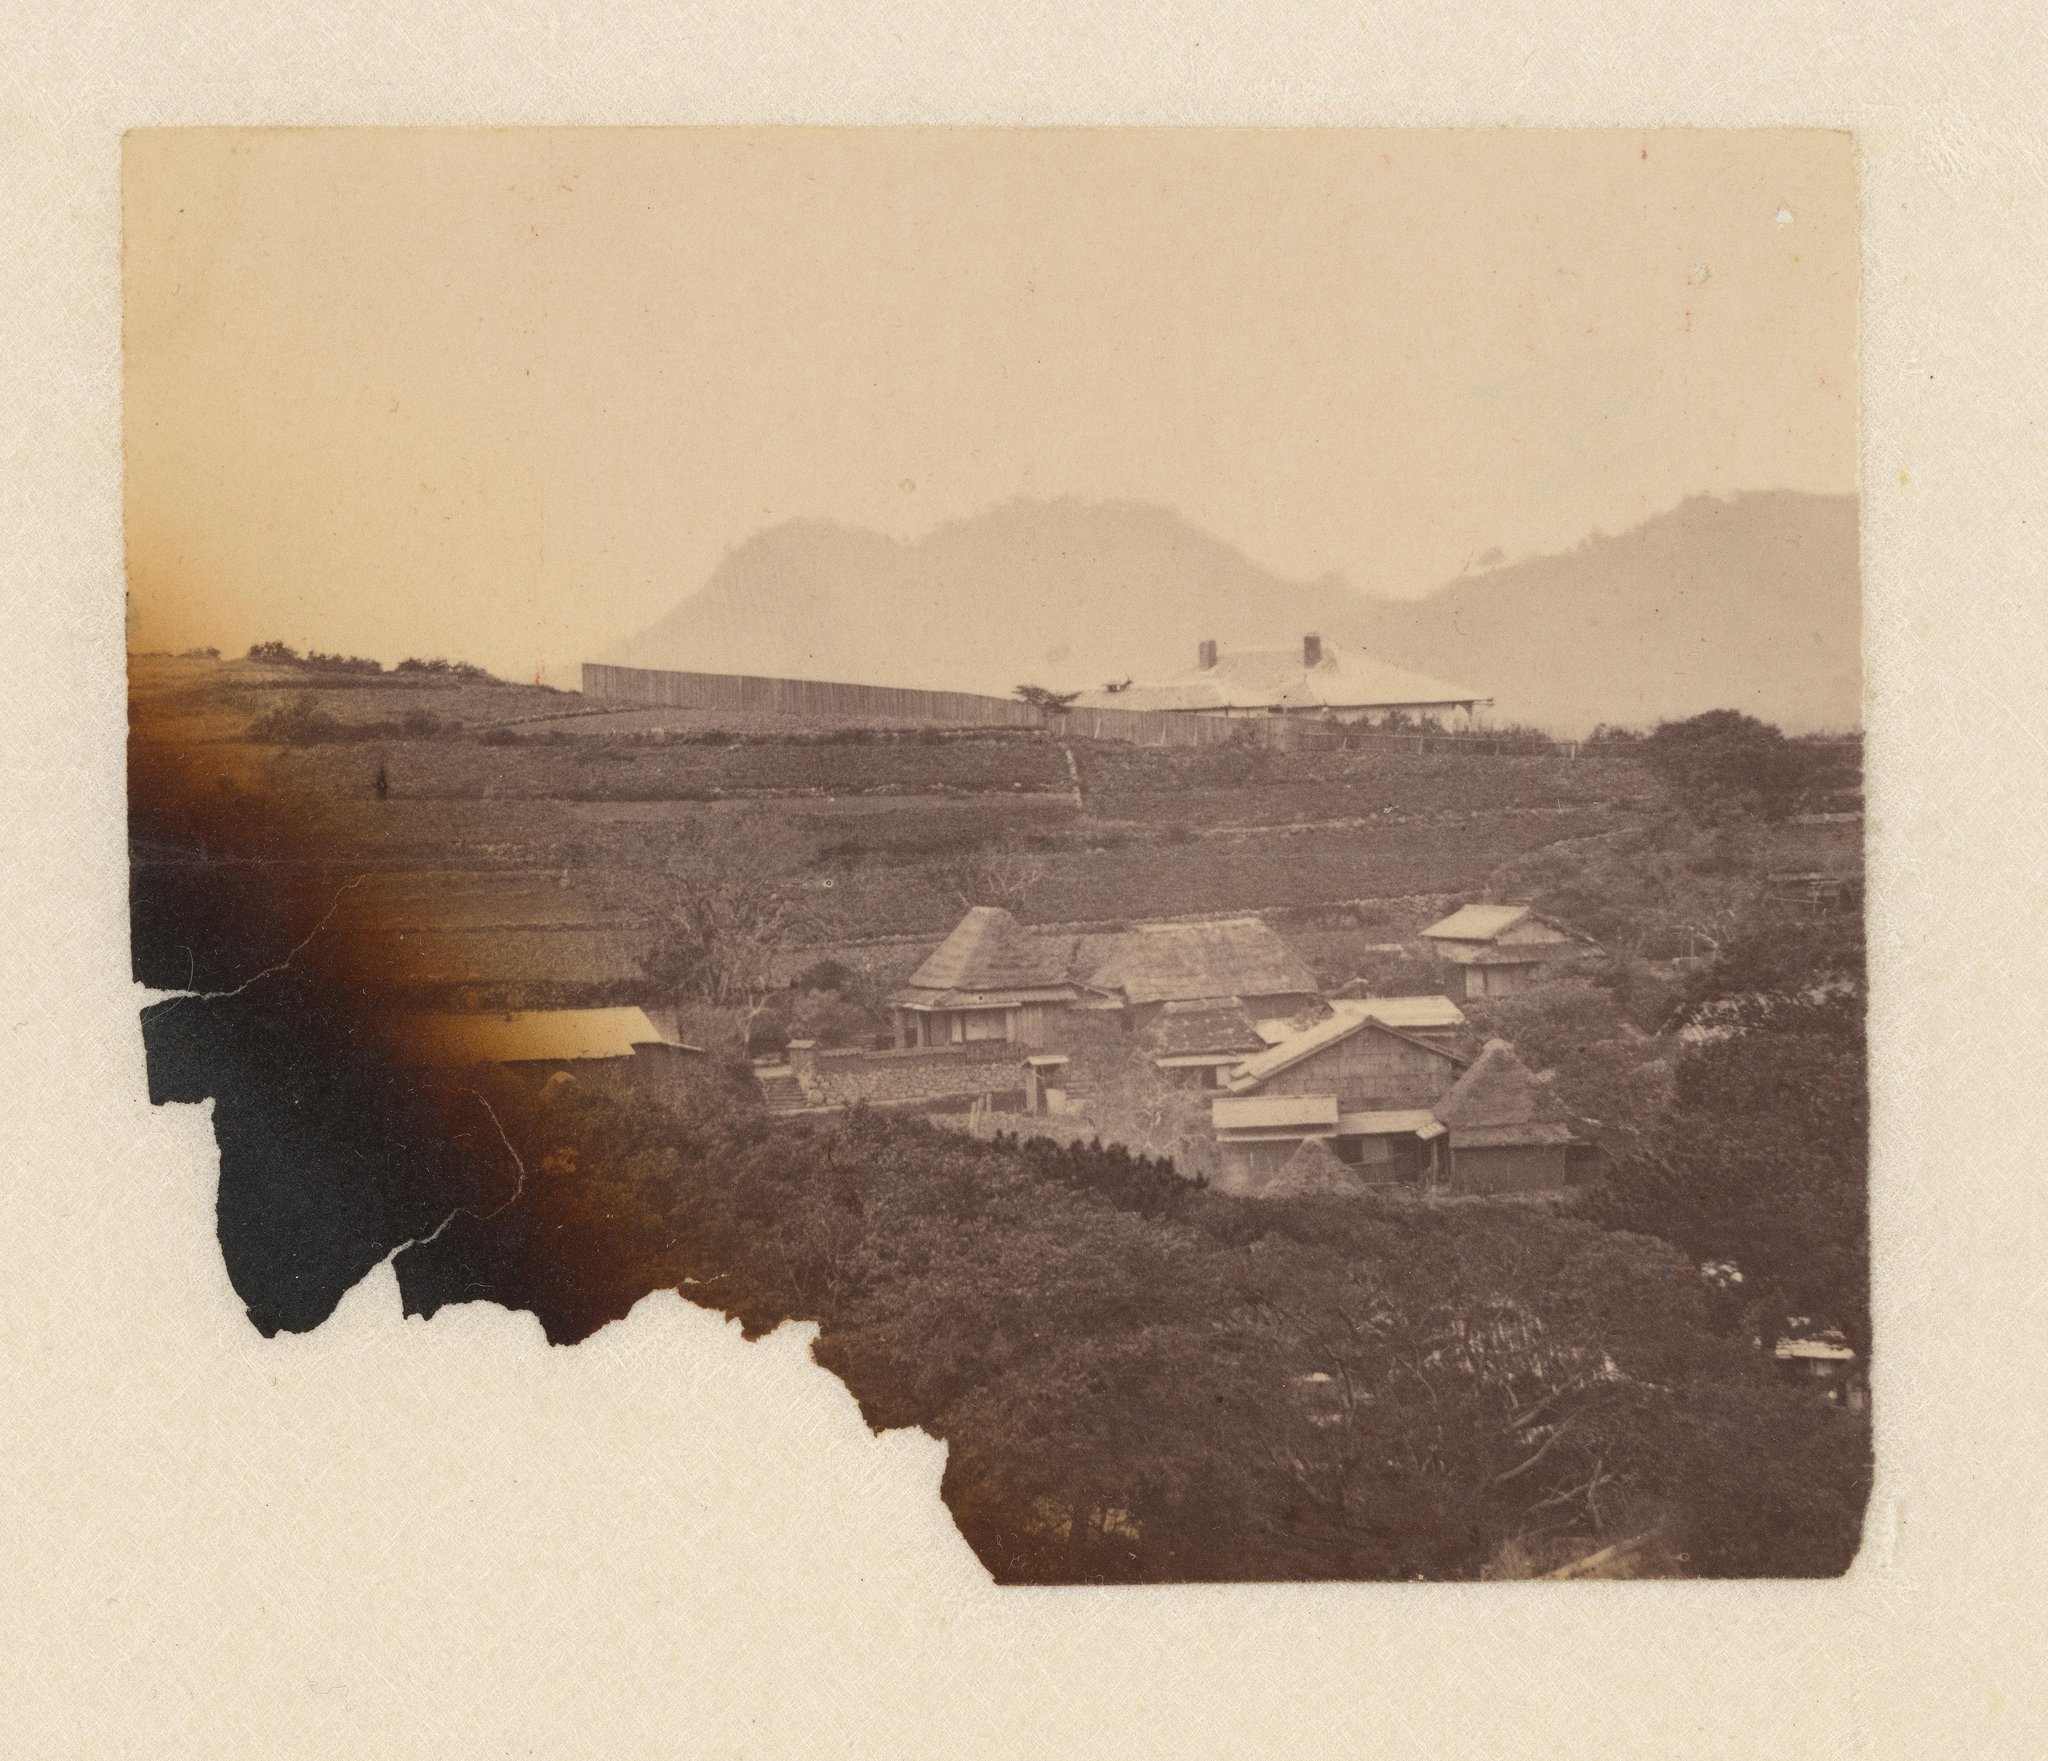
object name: photograph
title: Landscape near Nagasaki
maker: antoon bauduin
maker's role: amateurfotograaf, hoogleraar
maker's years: 1820-1885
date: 1862-1866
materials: paper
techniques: albumen print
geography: japan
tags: city-view, and landscape with man-made constructions, japan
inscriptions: number: ‘64’